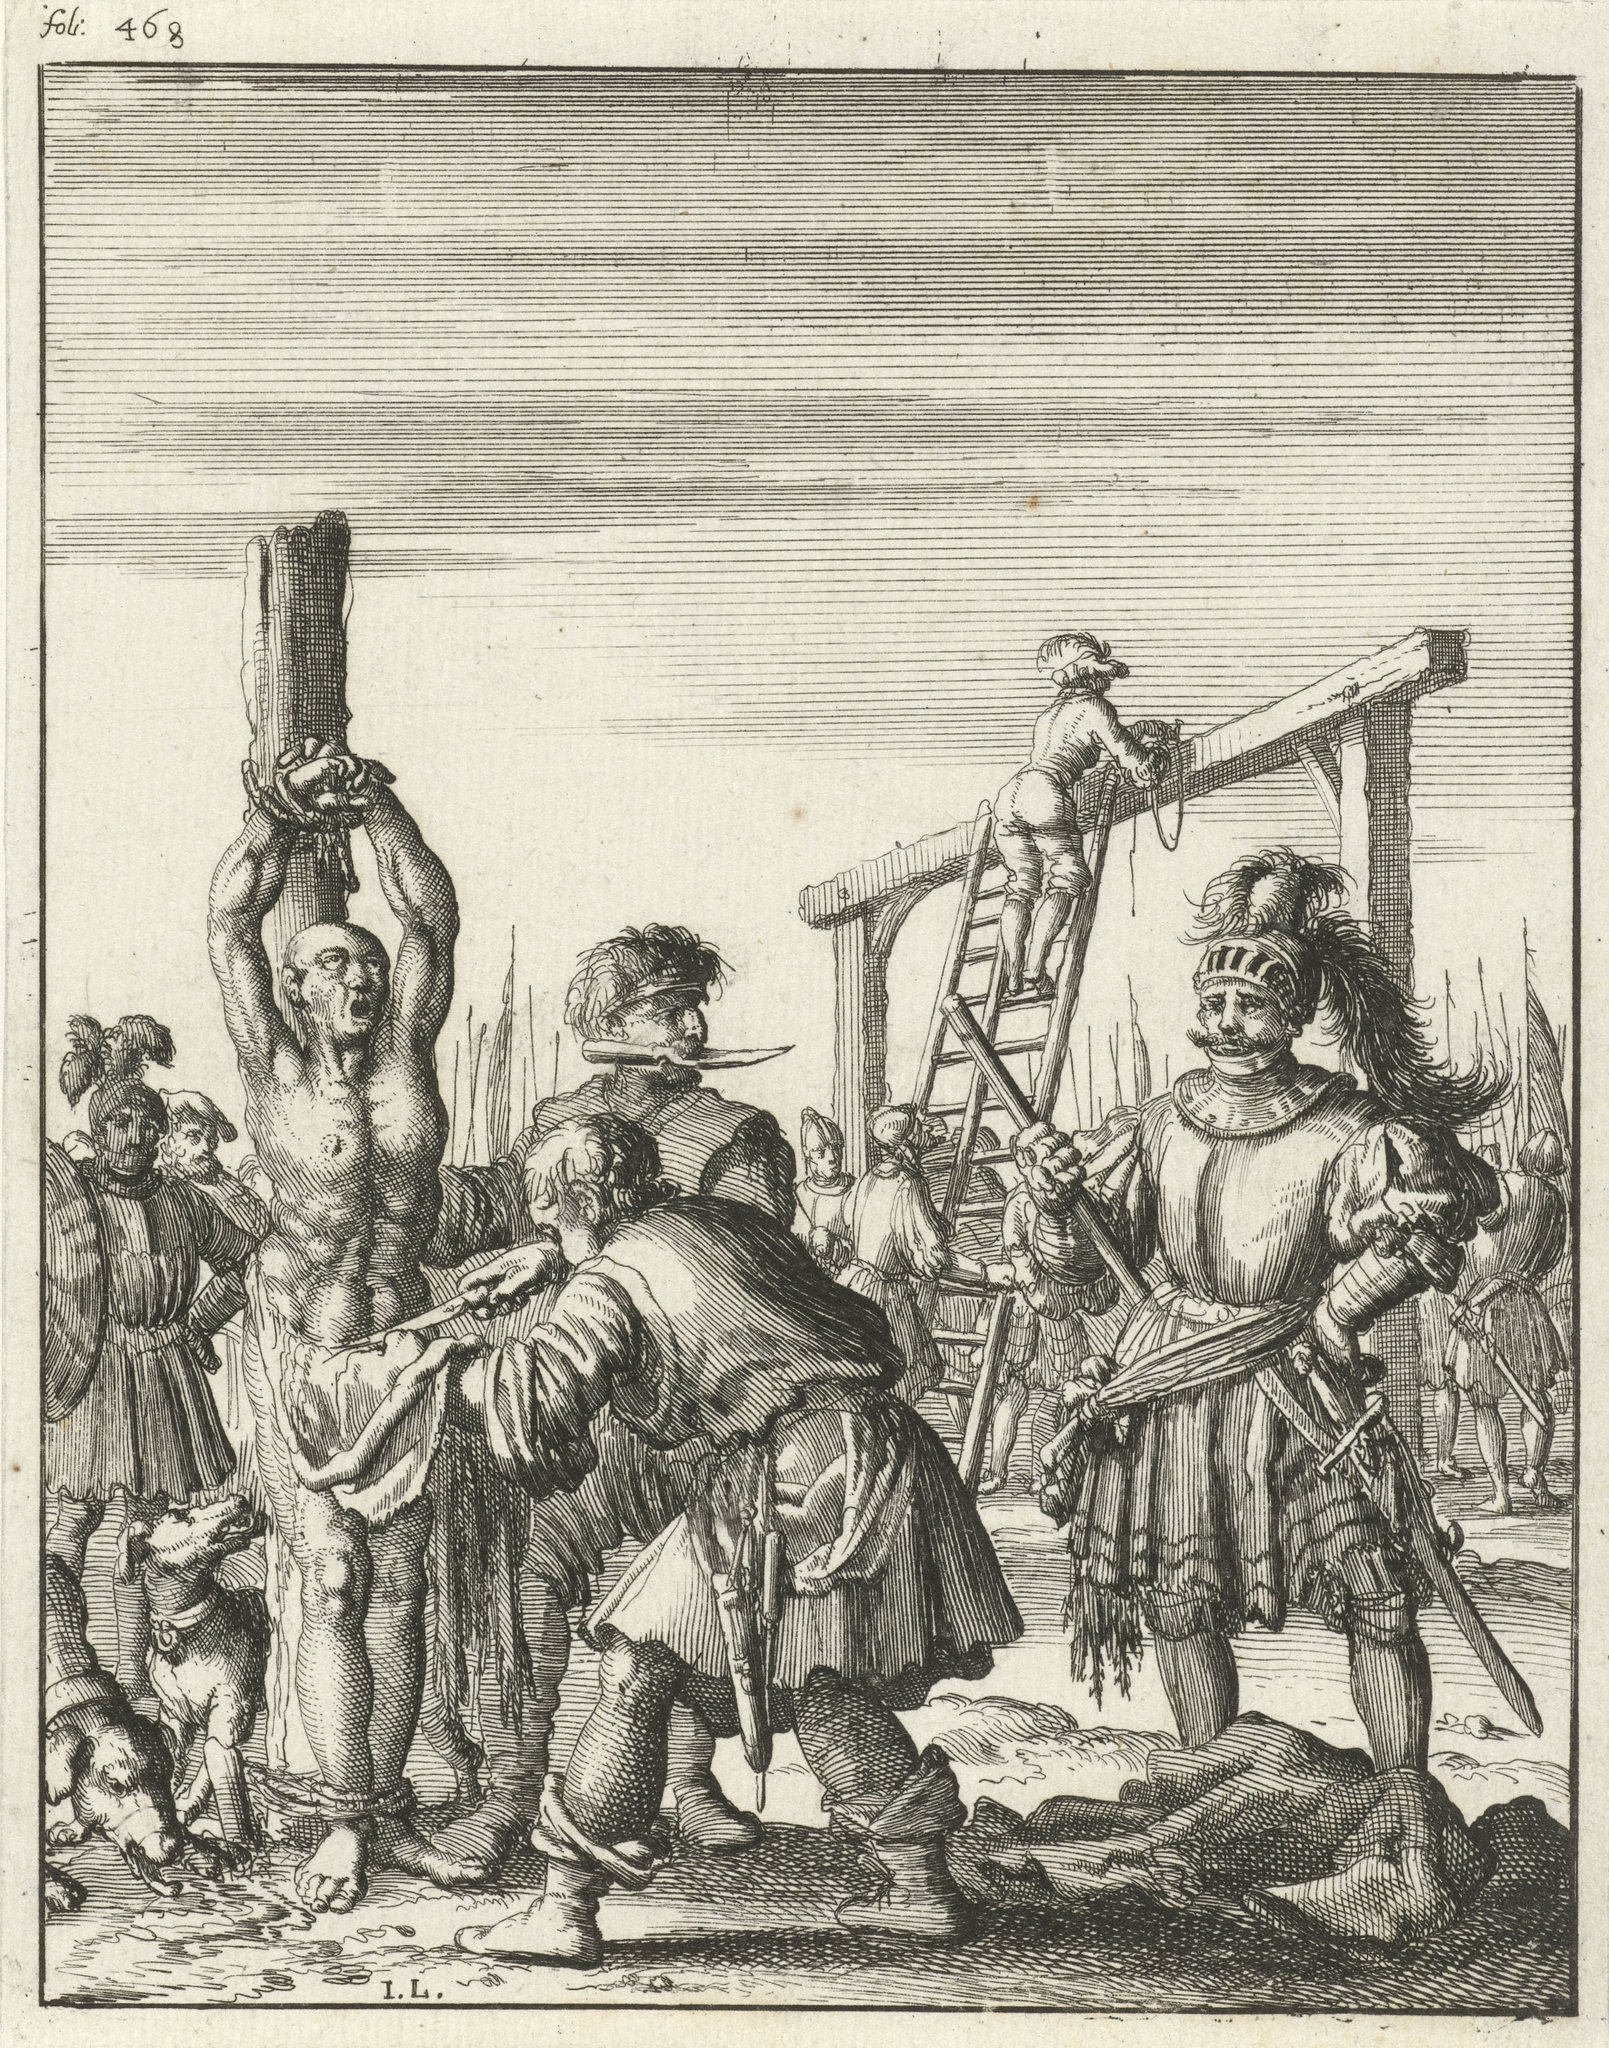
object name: print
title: Bertrand de Gourdon, door wiens schot Richard Leeuwenhart dodelijk gewond raakte, wordt levend gevild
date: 1683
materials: paper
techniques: etching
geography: amsterdam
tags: violent death by flaying, militant proselytizing: religious war, crusade, etc.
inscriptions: collector's mark: Lugt 2228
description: Illustratie opgenomen in: Maimbourg, Louis. Historie der kruisvaarders, tot de verlossing van't heilig land. Amsterdam: Timotheus ten Hoorn, 1683.